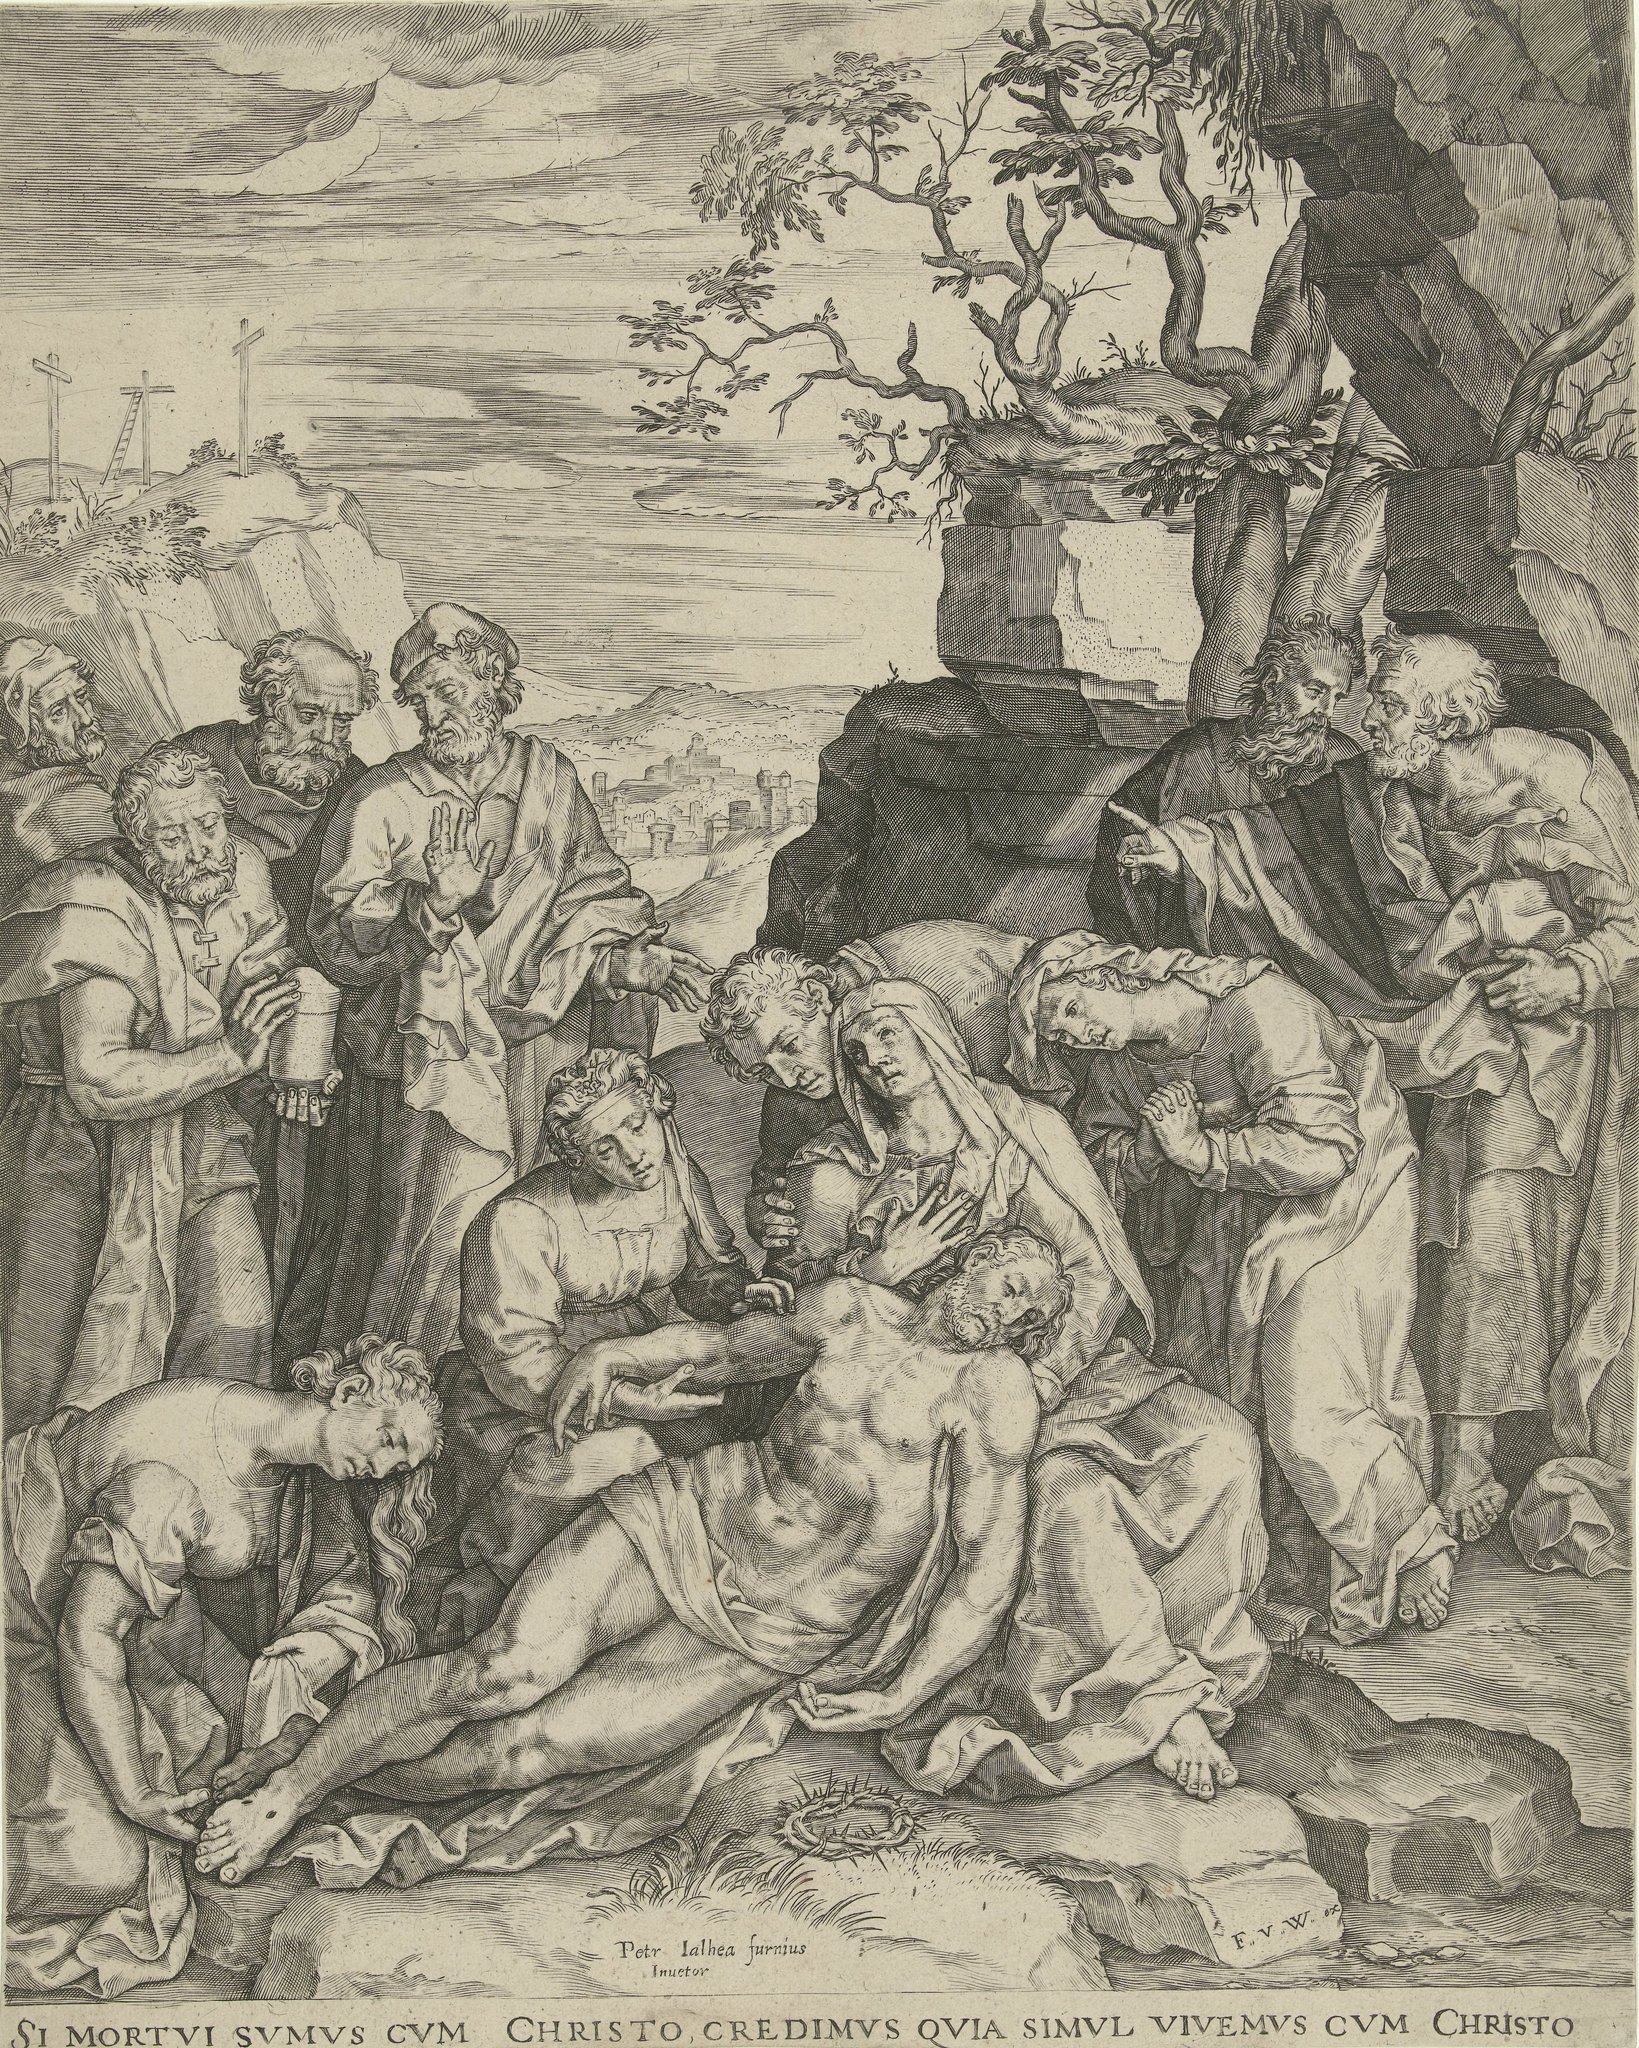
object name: print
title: Bewening van Christus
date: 1624-1679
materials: paper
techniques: engraving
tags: lamentation over the dead christ by his relatives and friends (christ usually without crown of thorns)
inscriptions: collector's mark: Lugt 2228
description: Maria, Johannes en de drie Maria's zitten geknield bij het lichaam van Christus. Links en rechts hiervan kijken figuren toe, een van hen draagt een zalfpot. Voor Christus ligt de doornenkrans op de grond, links op de achtergrond zicht op de berg Golgotha. Onder de voorstelling staat een regel tekst in het Latijn.